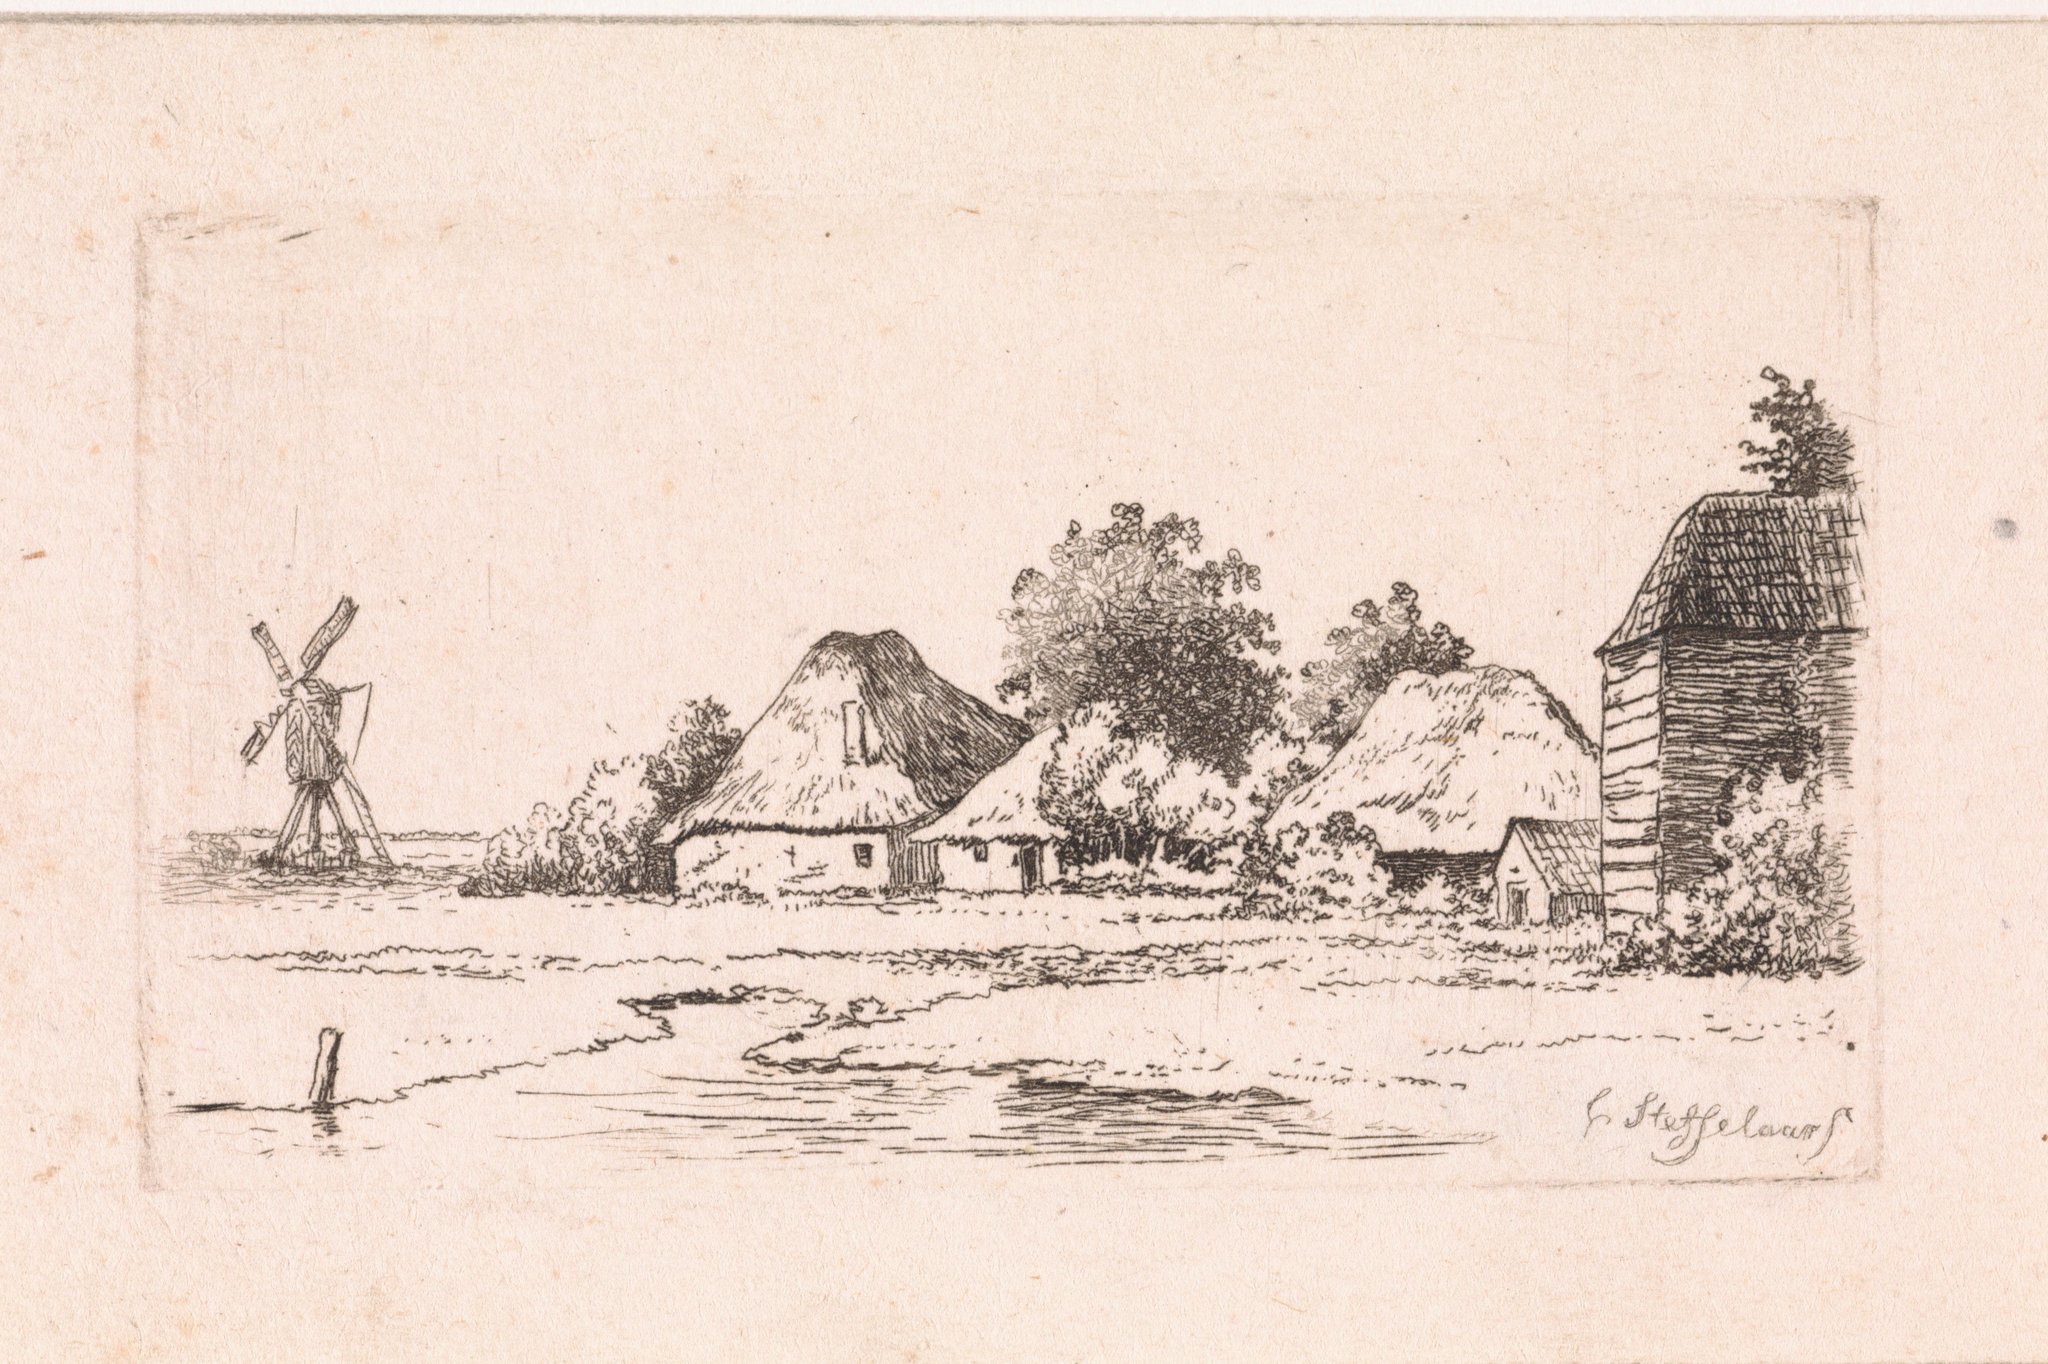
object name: print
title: Tweede suite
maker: cornelis steffelaar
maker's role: draughtsman, painter, print maker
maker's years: 1797-1861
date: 1845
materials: paper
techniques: etching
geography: amsterdam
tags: windmill in landscape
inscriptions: collector's mark: Lugt 2227